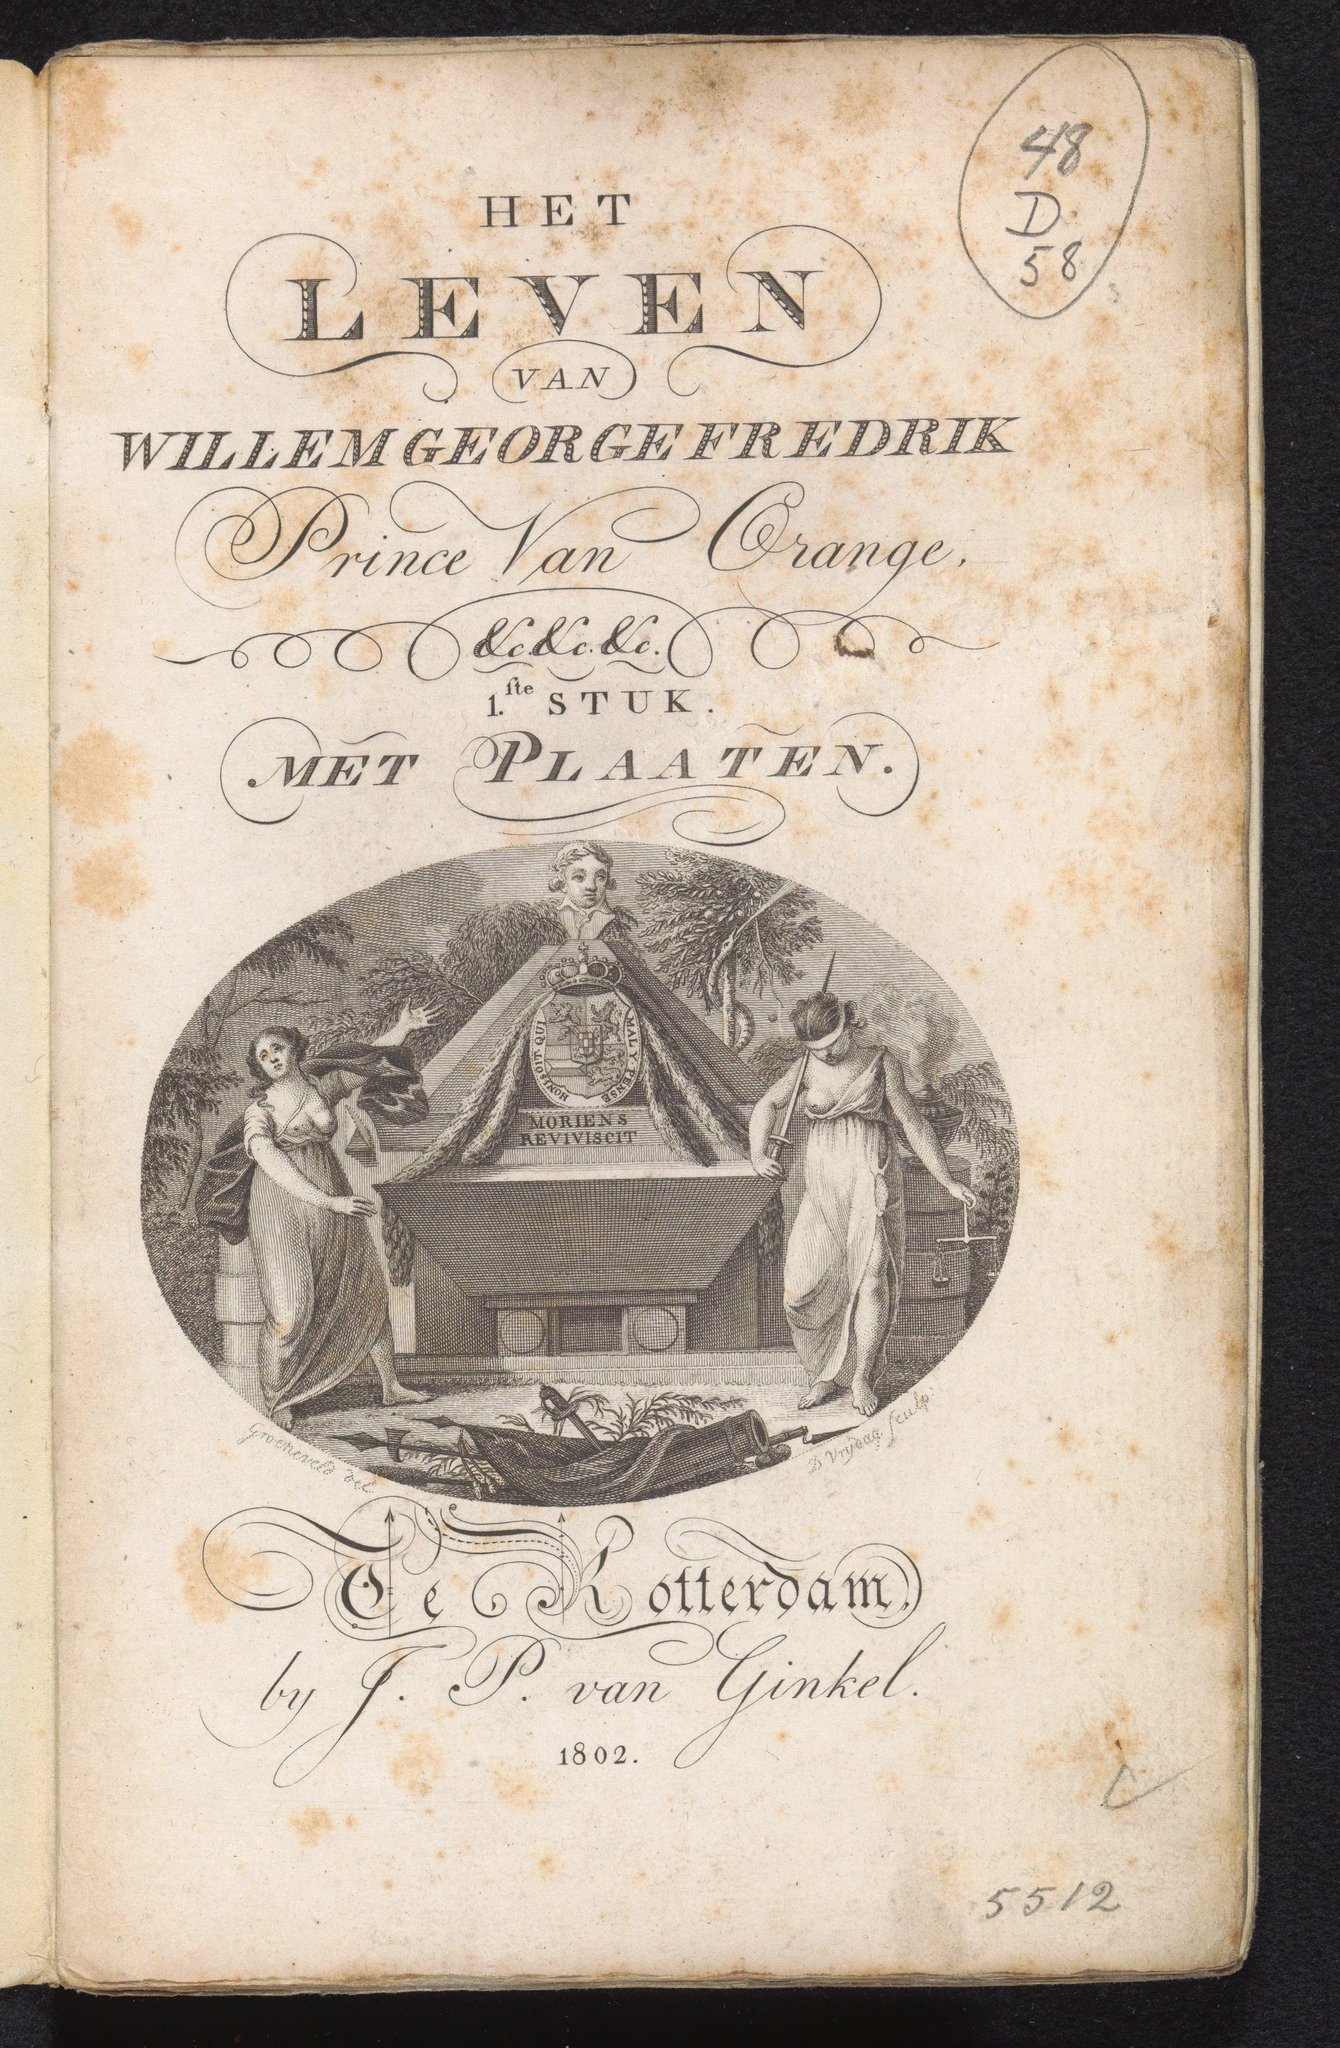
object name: print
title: Titelpagina voor: Het Leven van Willem George Fredrik, dl. I (1802)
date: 1802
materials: paper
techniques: engraving, etching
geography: rotterdam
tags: the hague, willem george frederik (prins van oranje-nassau), grave-building, monumental tomb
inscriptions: collector's mark: Lugt 2166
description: Gegraveerde titelpagina met titel en allegorisch vignet met graftombe van prins Frederik. Illustratie in het vierdelige Leven van Willem George Fredrik (1802-1803).